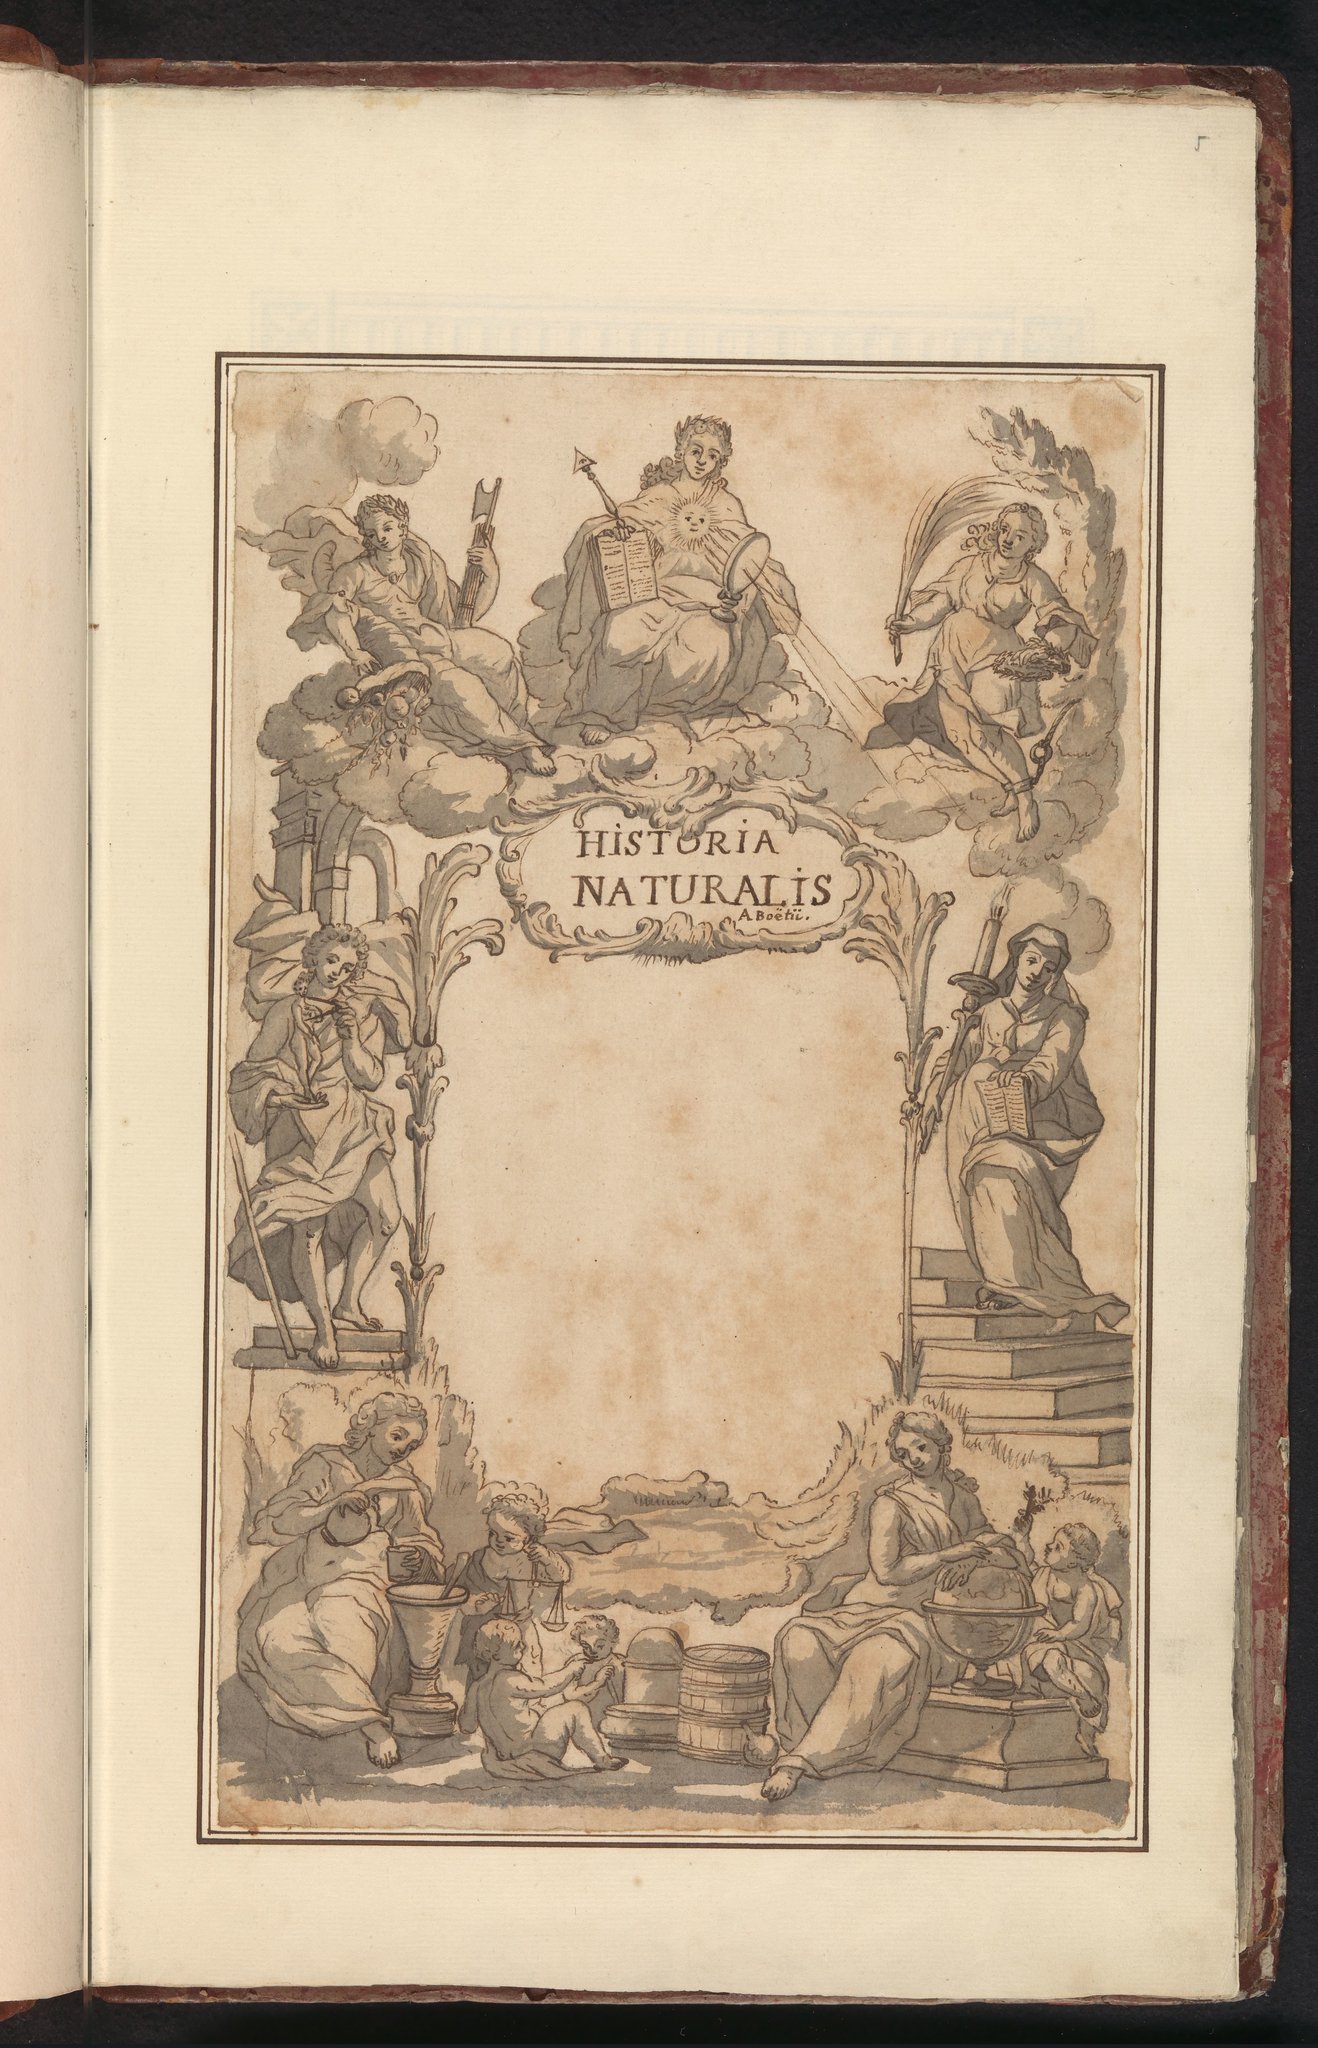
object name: drawing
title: Titelpagina met allegorische omlijsting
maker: Anonymous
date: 1809-1814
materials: ink, paper, watercolor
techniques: brush, pen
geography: southern netherlands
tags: title-page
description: Titelpagina met omlijsting met zeven allegorische vrouwelijke figuren. Onderdeel van het eerste album met tekeningen van viervoeters. Eerste van twaalf albums met tekeningen van dieren, vogels en planten bekend rond 1600, gemaakt in opdracht van keizer Rudolf II. Met toelichting in Nederlands, Latijn en Frans.